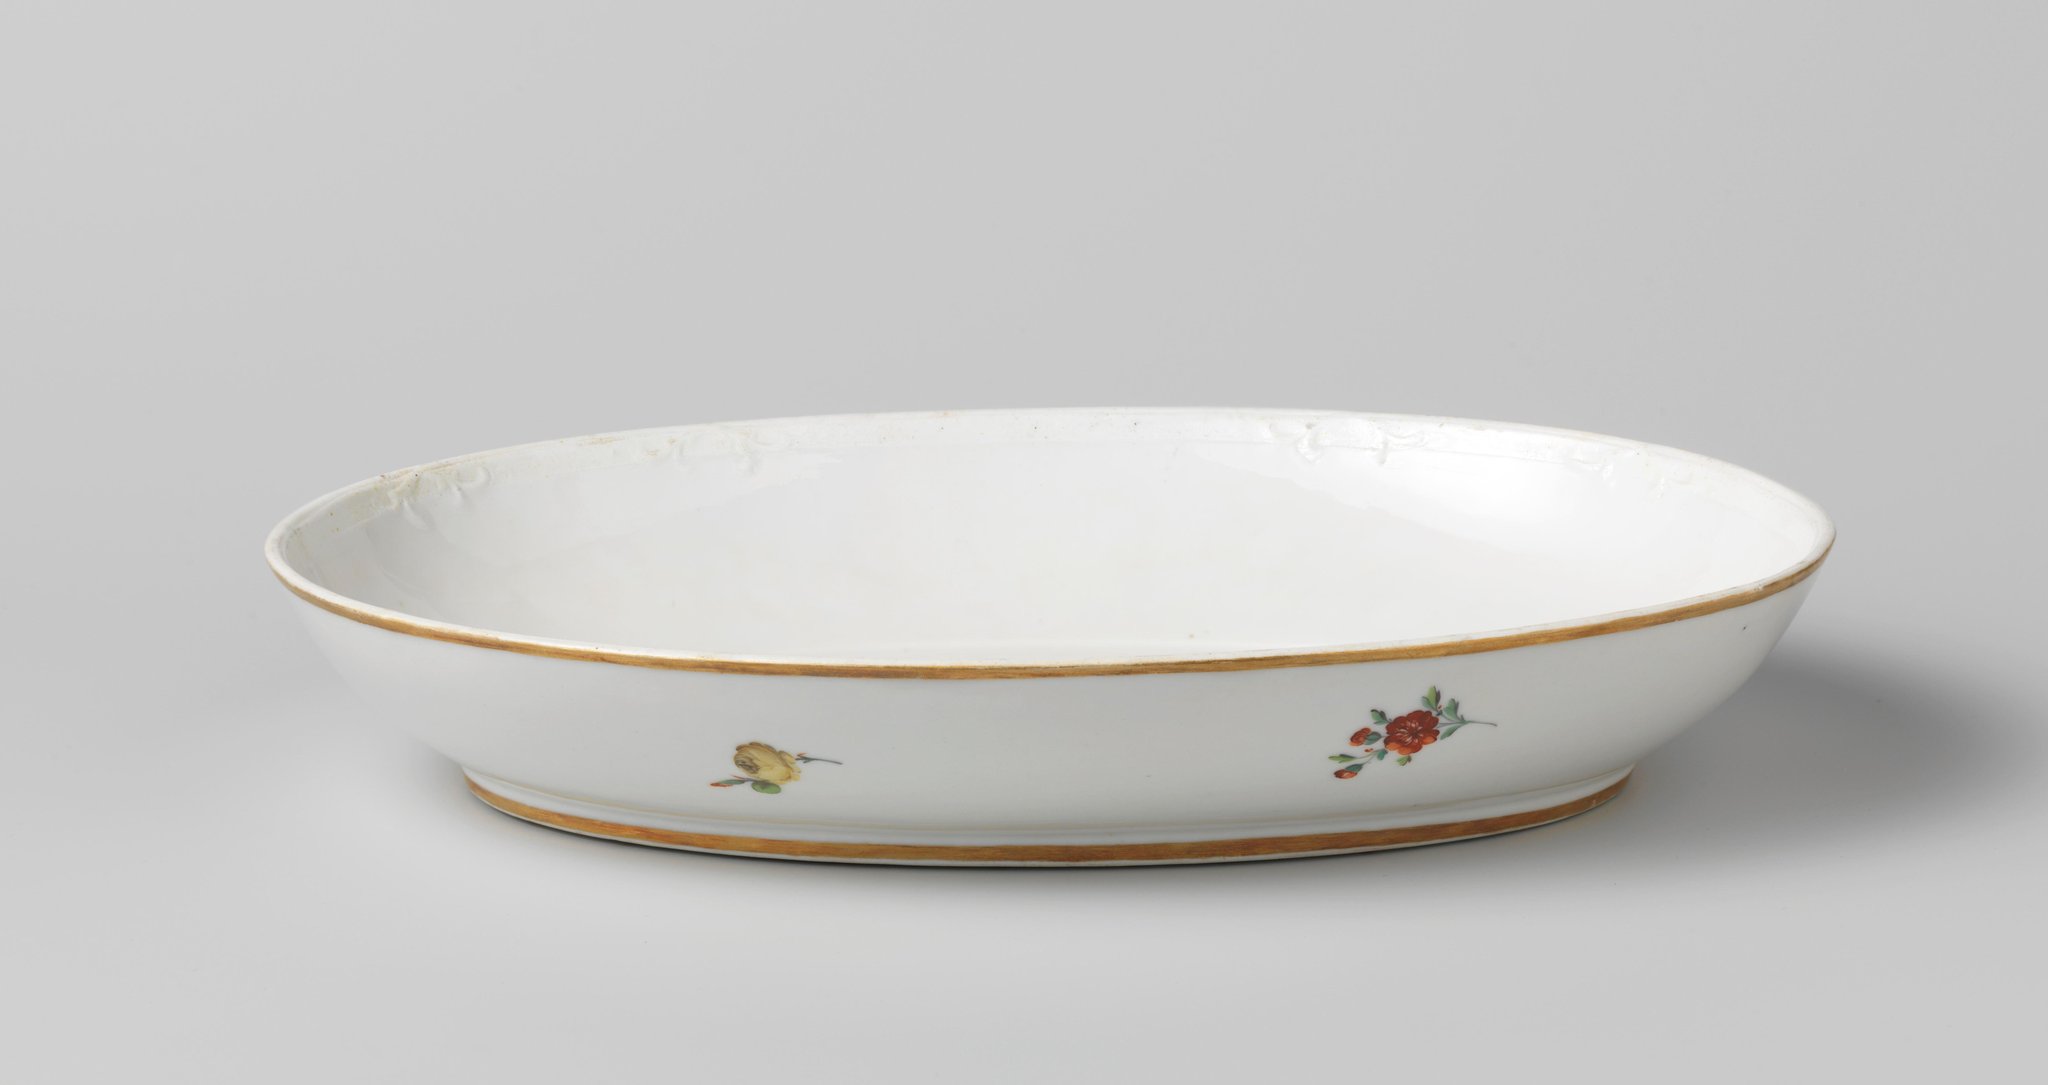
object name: dish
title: Schaal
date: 1784-1814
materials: porcelain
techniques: painted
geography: amstel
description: Ovale schaal veelkleurig beschilderd met strooibloemen met gestileerde bladeren in relief. Gemerkt: Amstel.